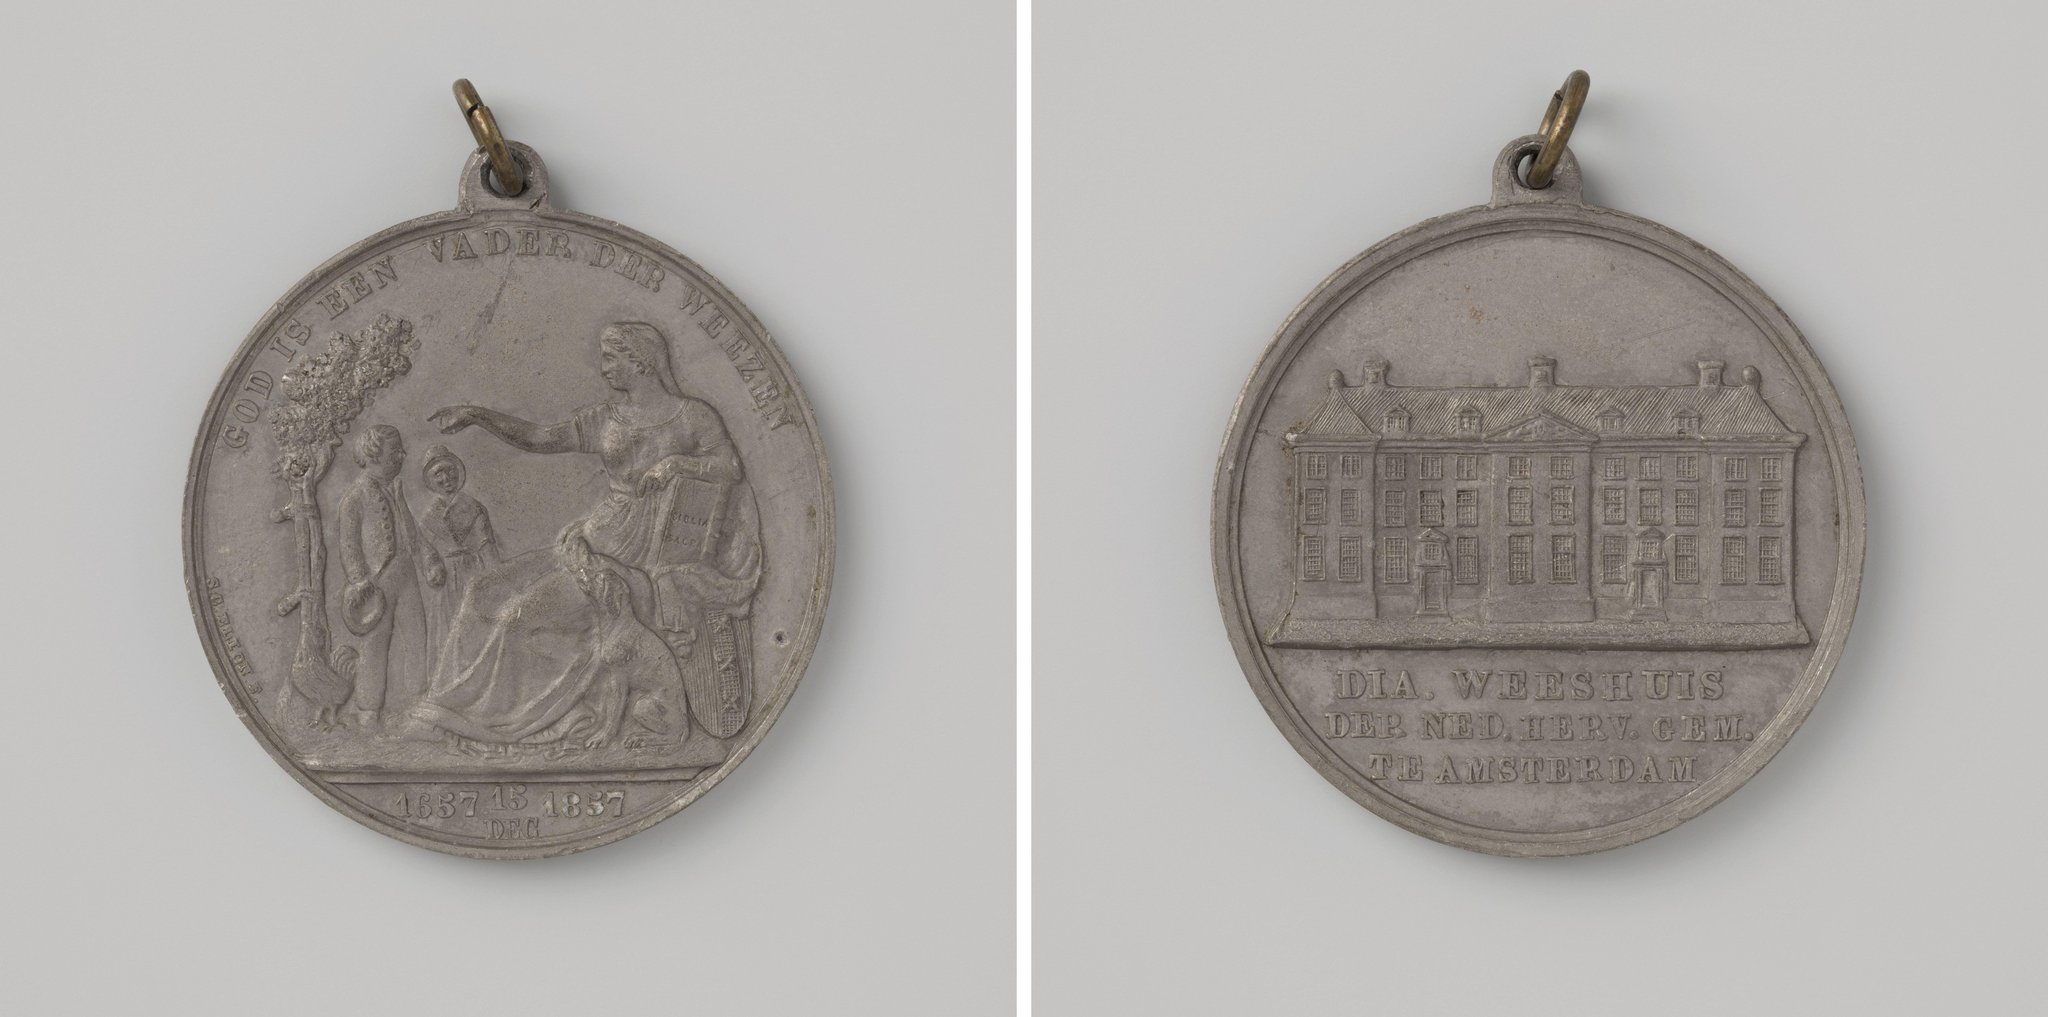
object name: history medal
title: Tweehonderdjarig bestaan van het Diaconie Weeshuis van de Nederduitsche Hervormde Gemeente te Amsterdam, uitgedeeld aan de wezen 1857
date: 1857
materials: brass, tin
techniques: striking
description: Tinnen penning met oog en draagring, op de voorzijde de Liefdadigheid als zittende vrouw met bijbel en hond, links twee wezen onder een gestutte jonge boom, met omschrift en afsnedetekst, op de keerzijde het vooraanzicht van het weeshuis boven drie regels tekst.